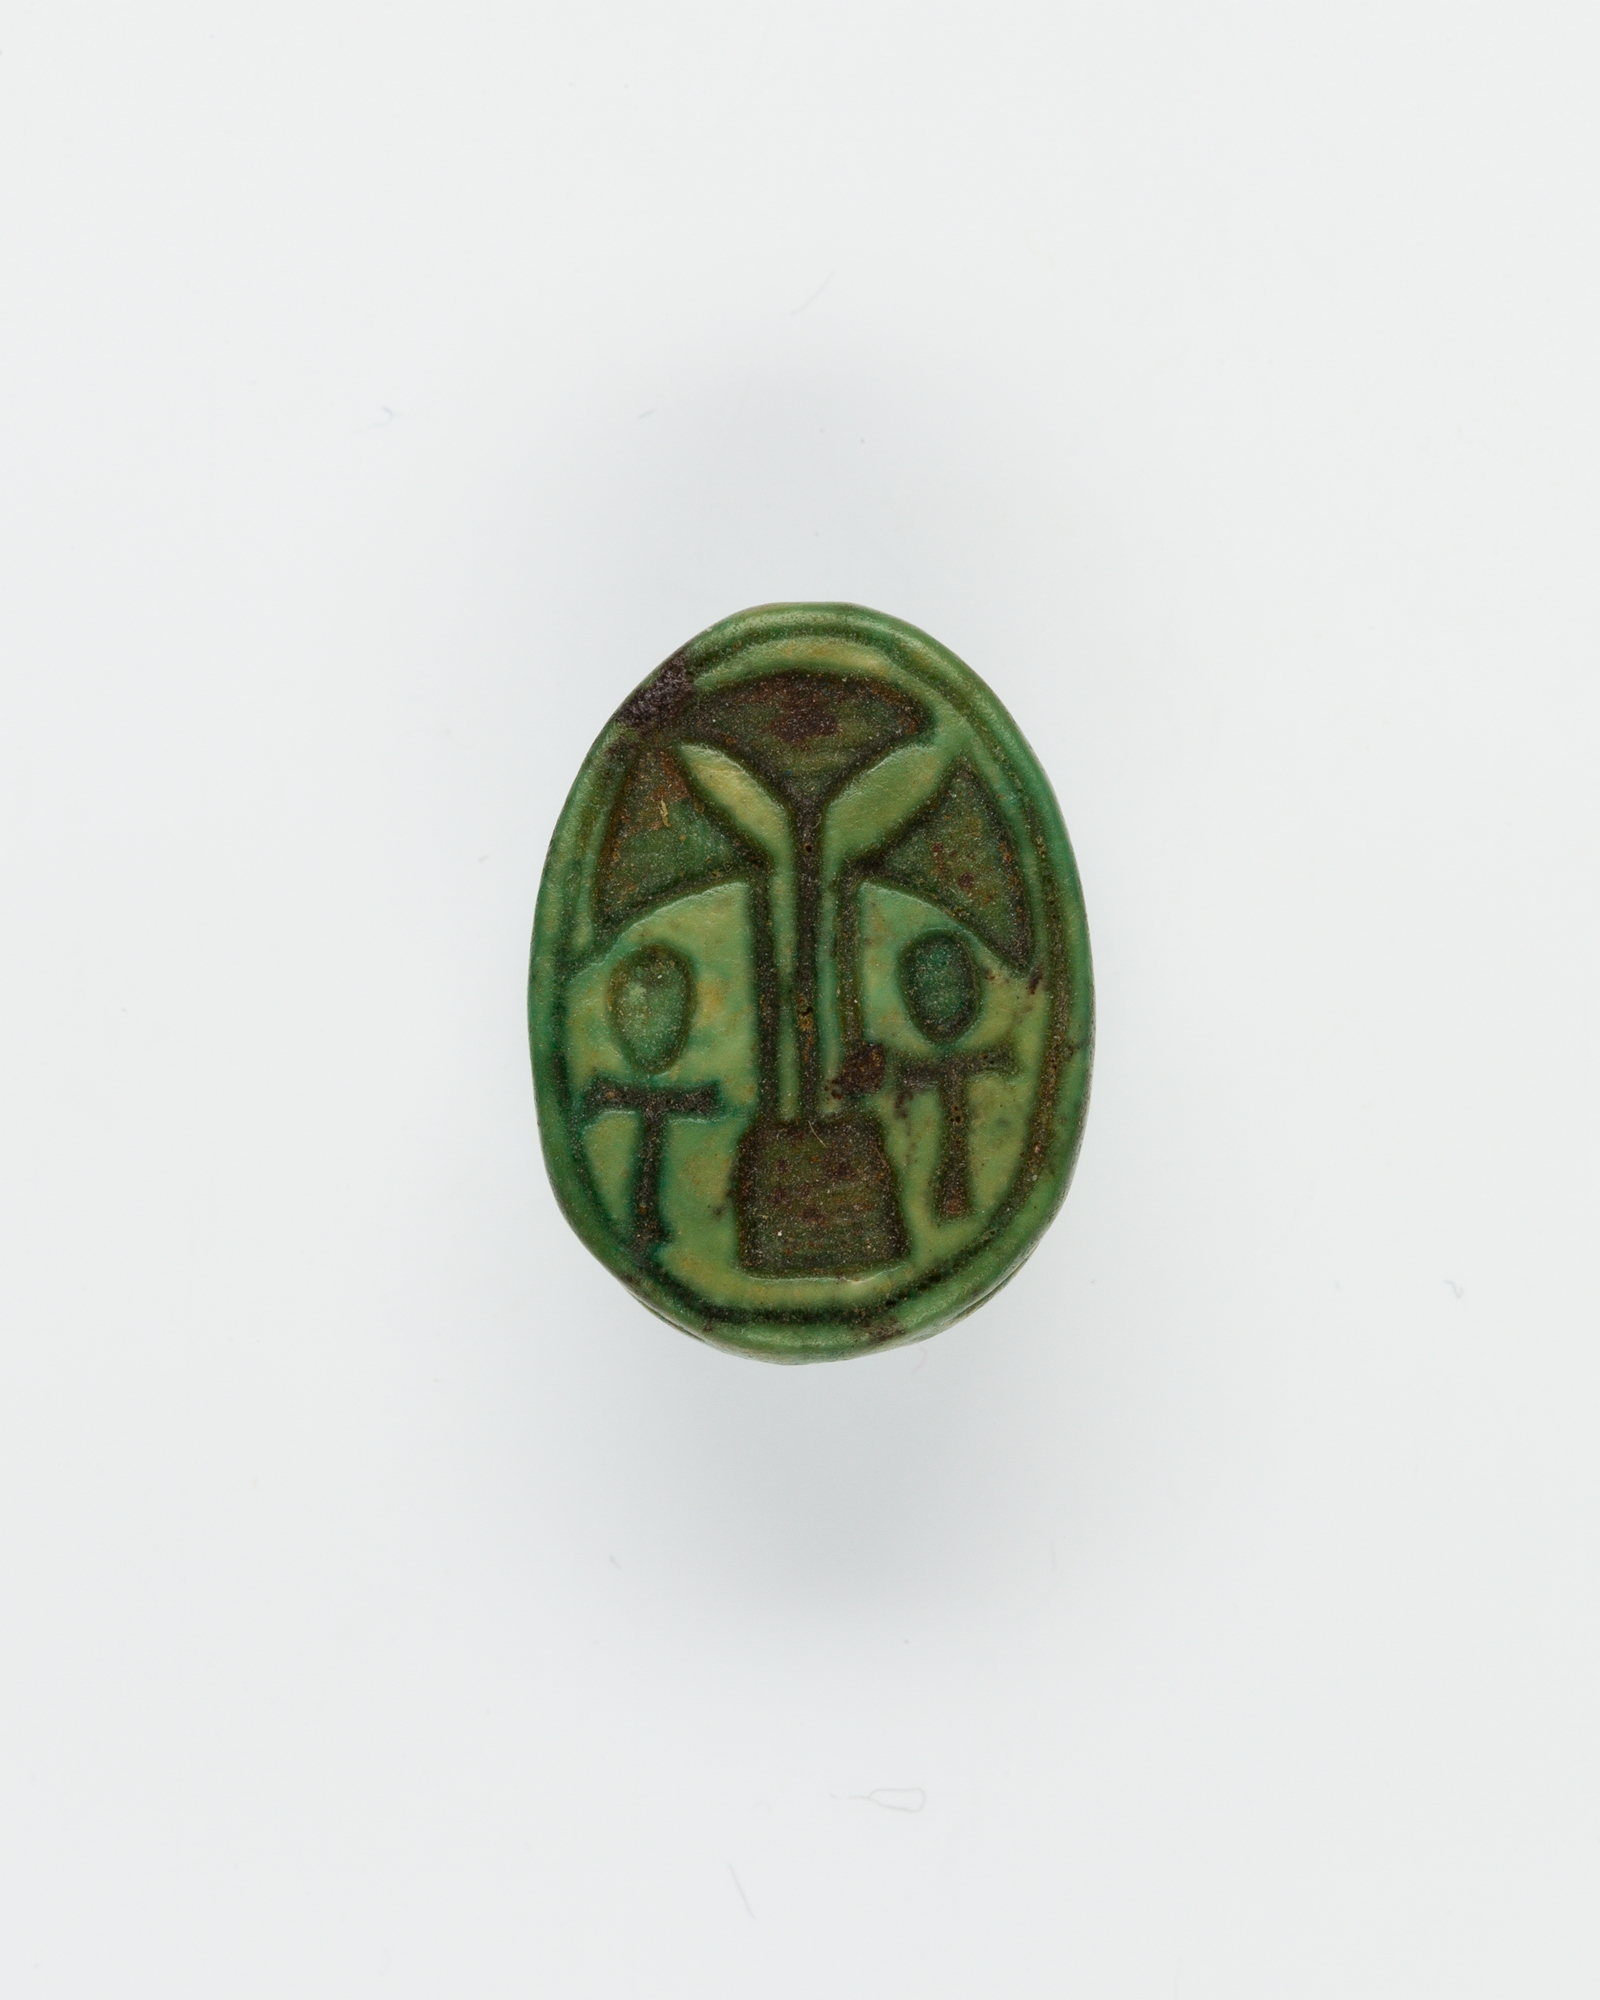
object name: scarab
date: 1492-1479 BCE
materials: stone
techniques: glazing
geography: egypt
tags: scarabs